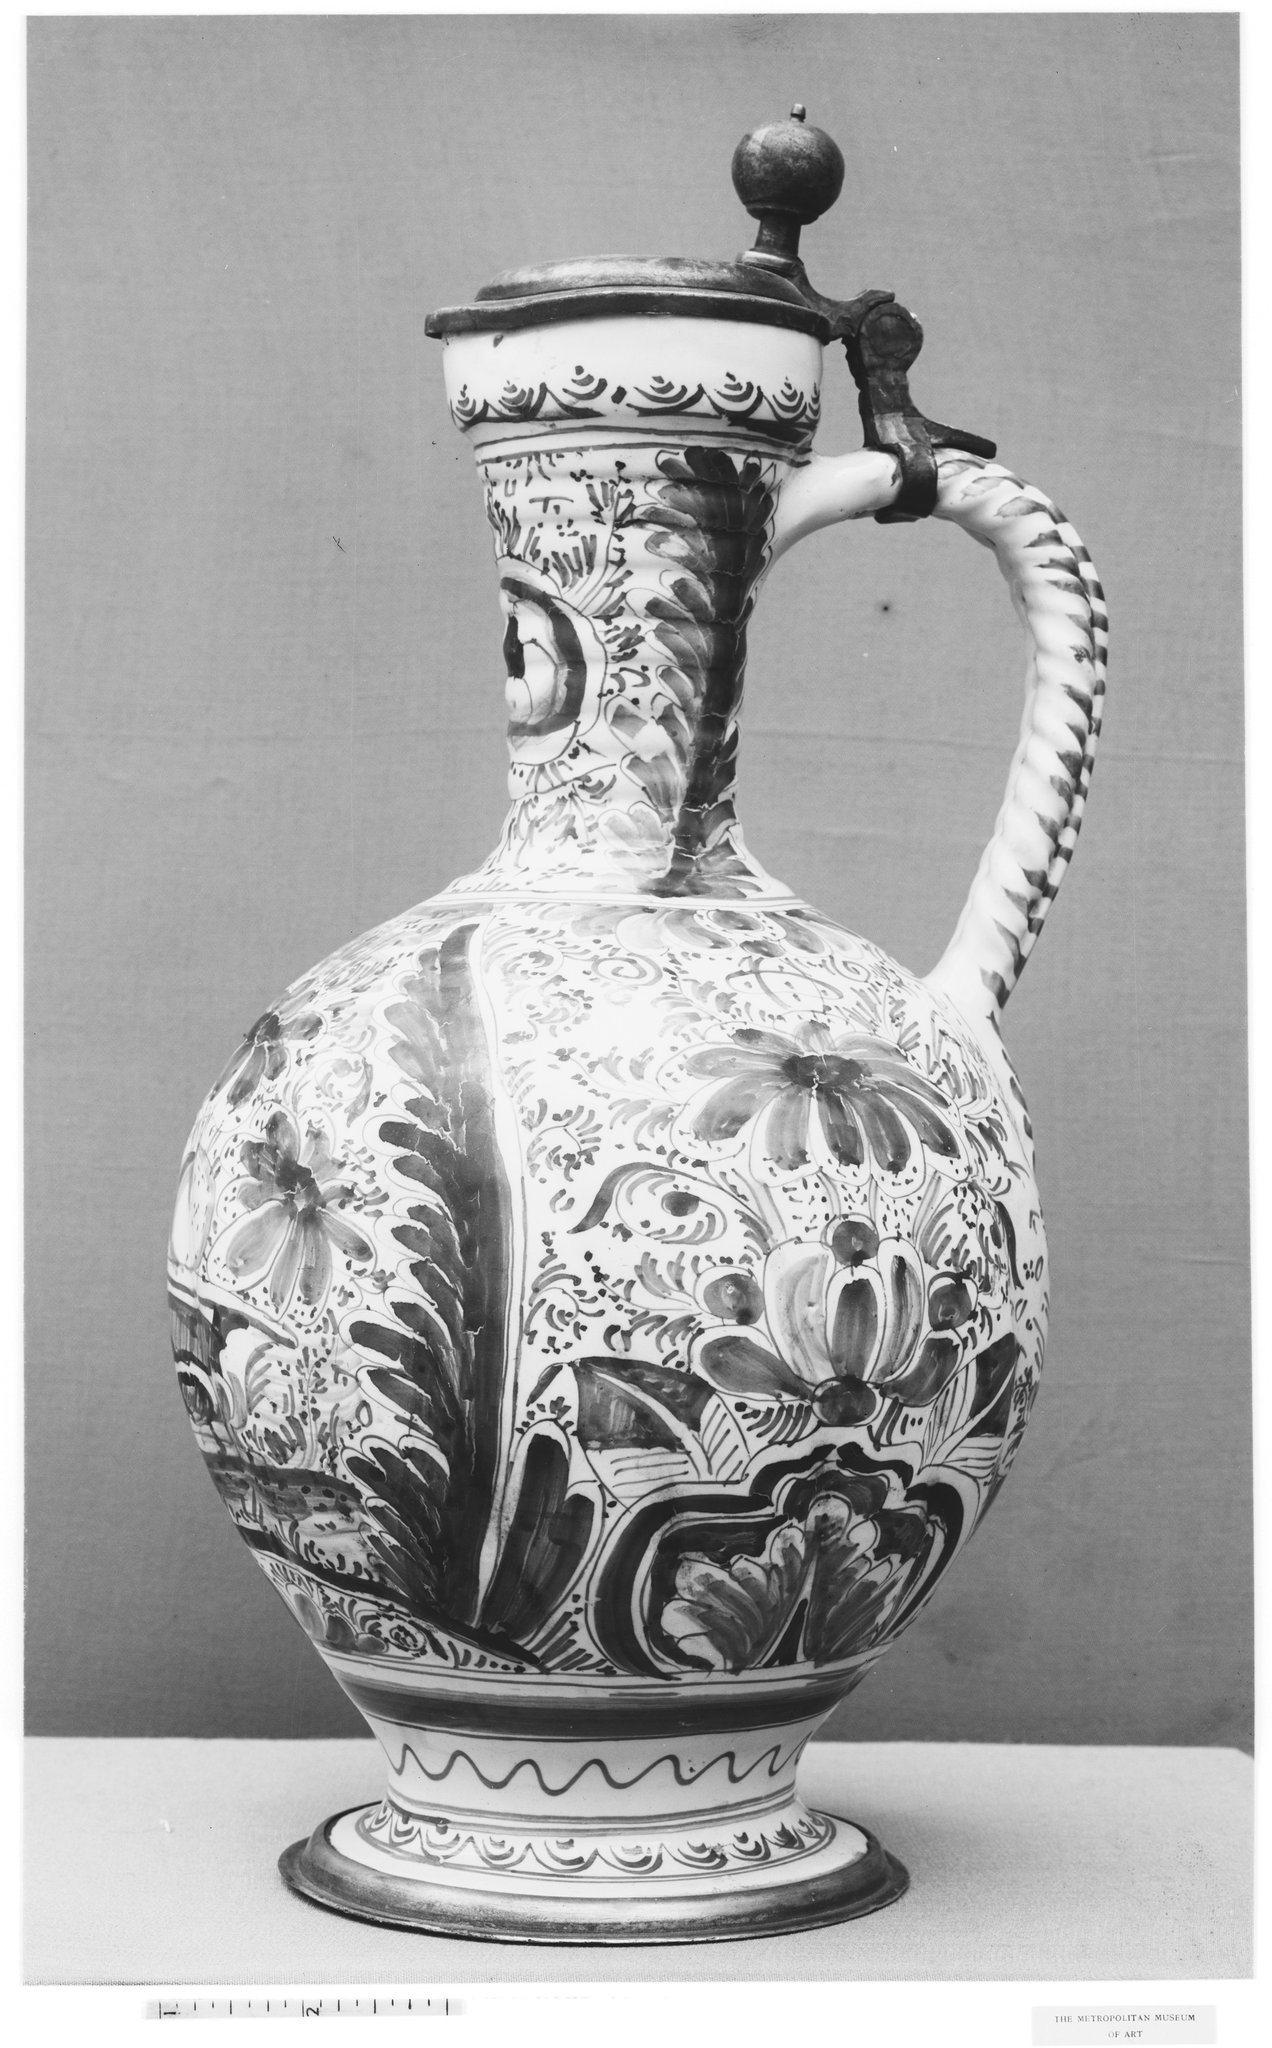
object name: jug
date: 1701-1750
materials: earthenware, pewter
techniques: glazing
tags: flowers